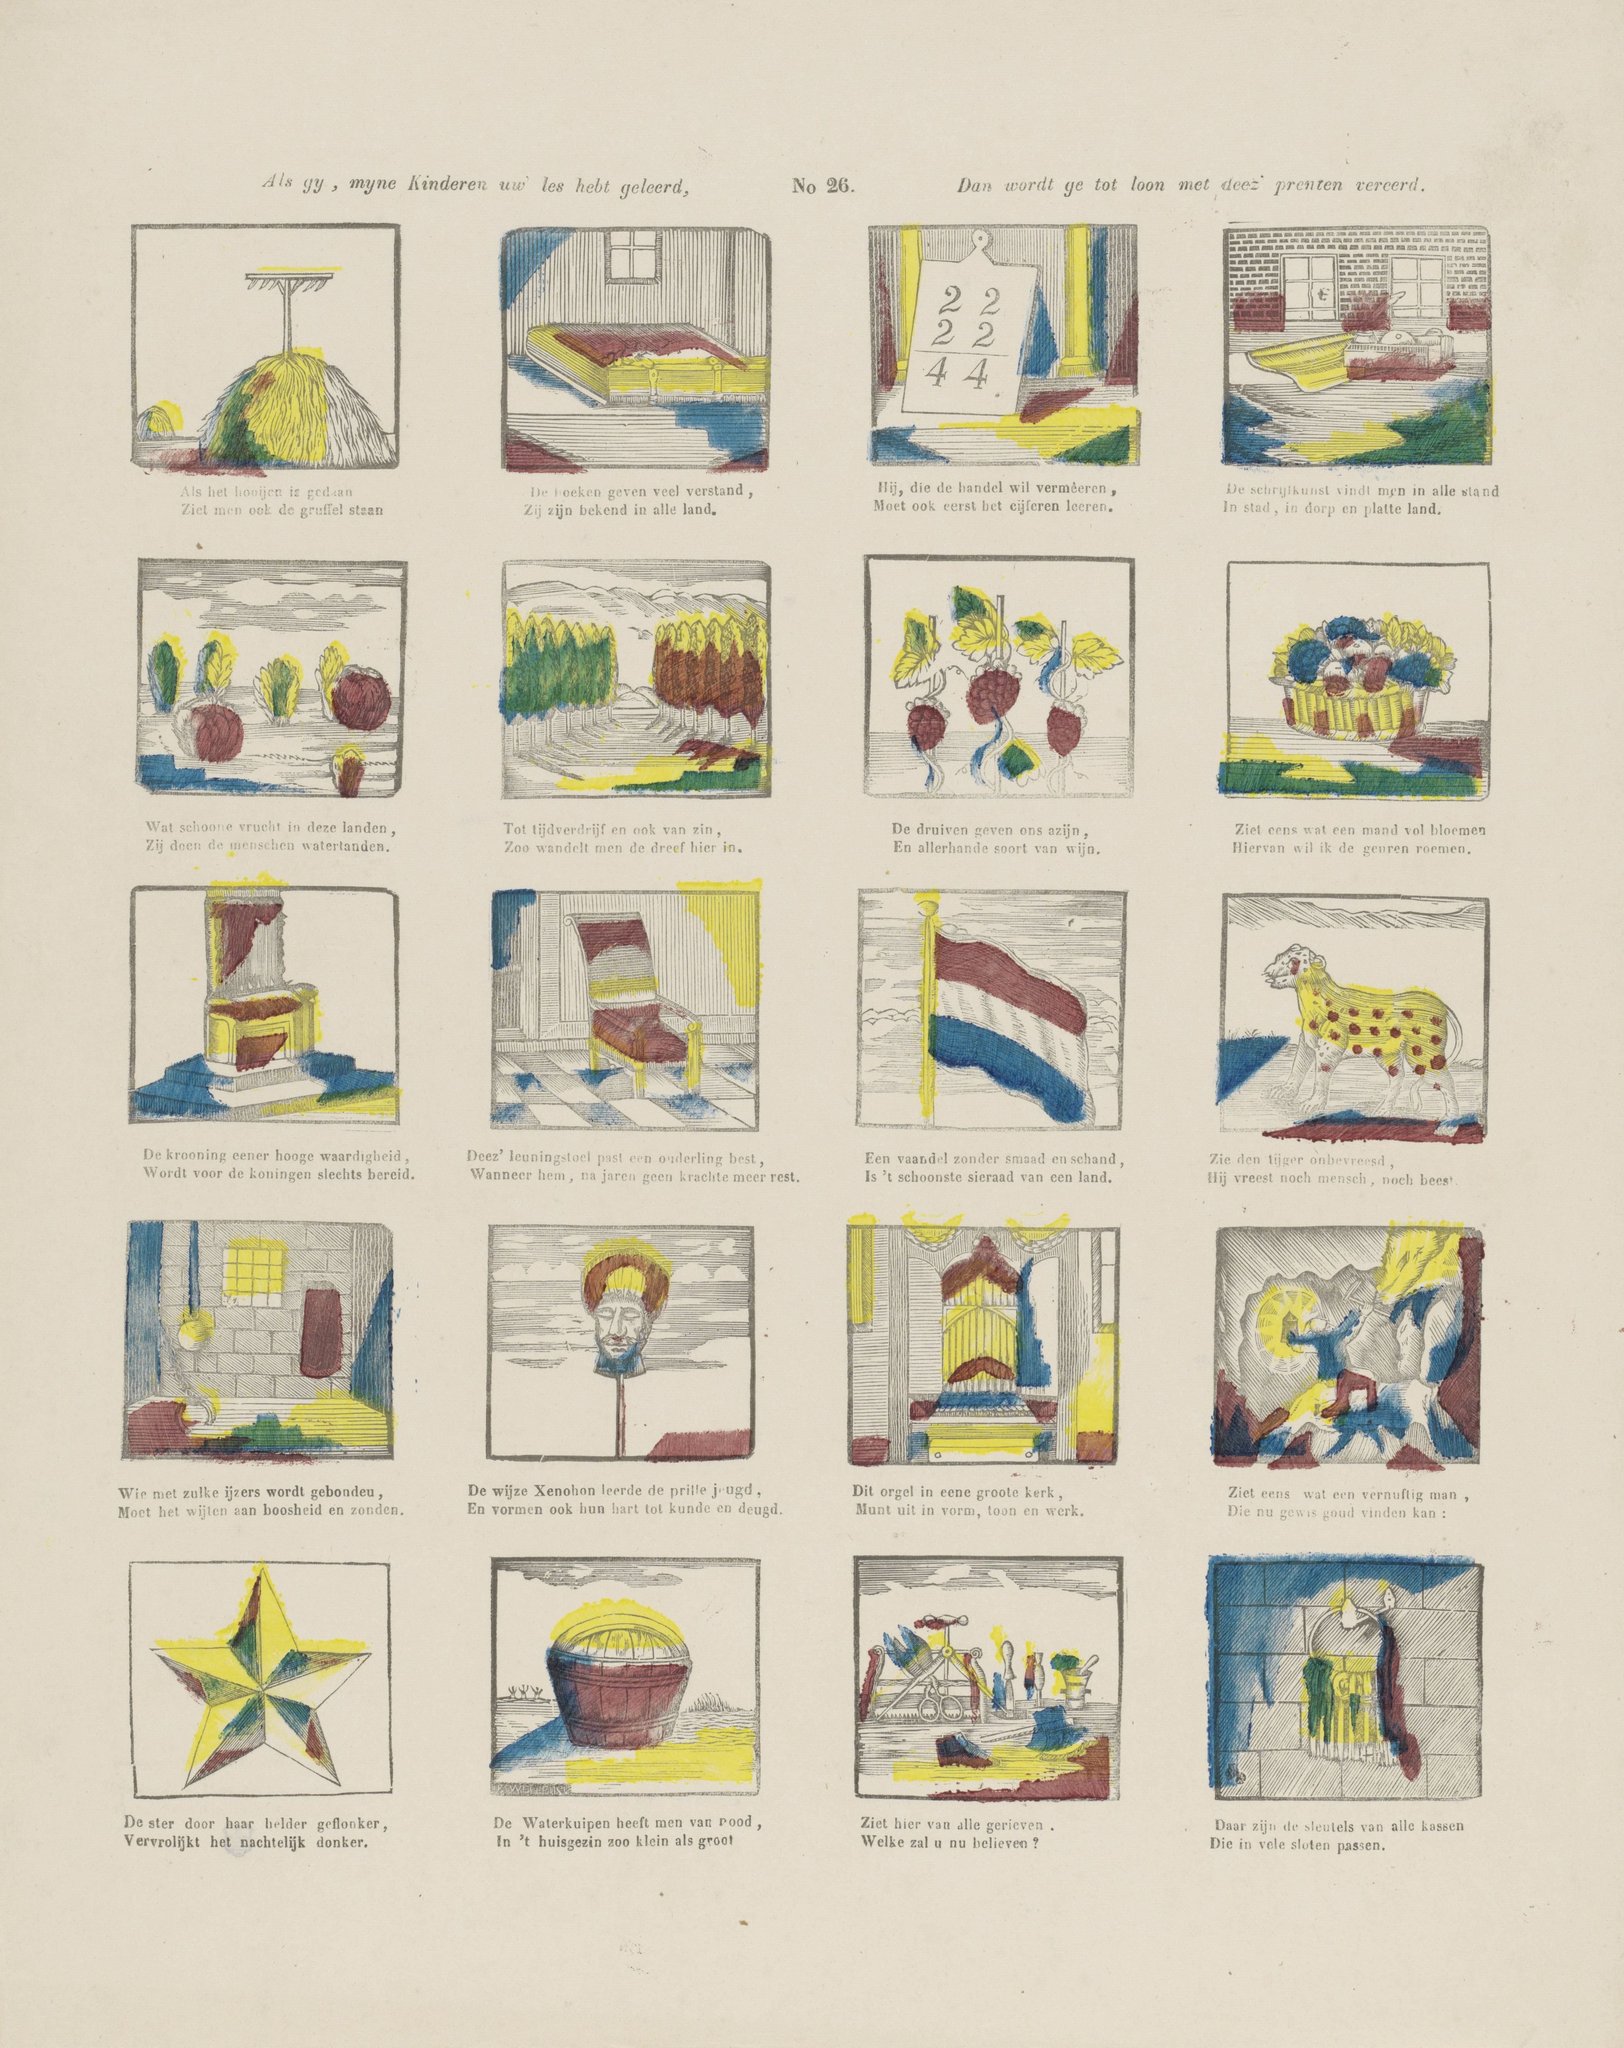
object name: print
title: Als gy, myne kinderen uw' les hebt geleerd, / Dan wordt ge tot loon met deez' prenten vereerd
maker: Anonymous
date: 1848-1881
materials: paper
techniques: colour, letterpress printing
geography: den bosch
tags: throne, book, stars, flags (~ signalling)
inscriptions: collector's mark: Lugt 2760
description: Blad met 20 voorstellingen van verschillende voorwerpen, zoals een boek, een troon en een ster. Onder elke afbeelding een tweeregelig vers. Genummerd midden boven: No 26.